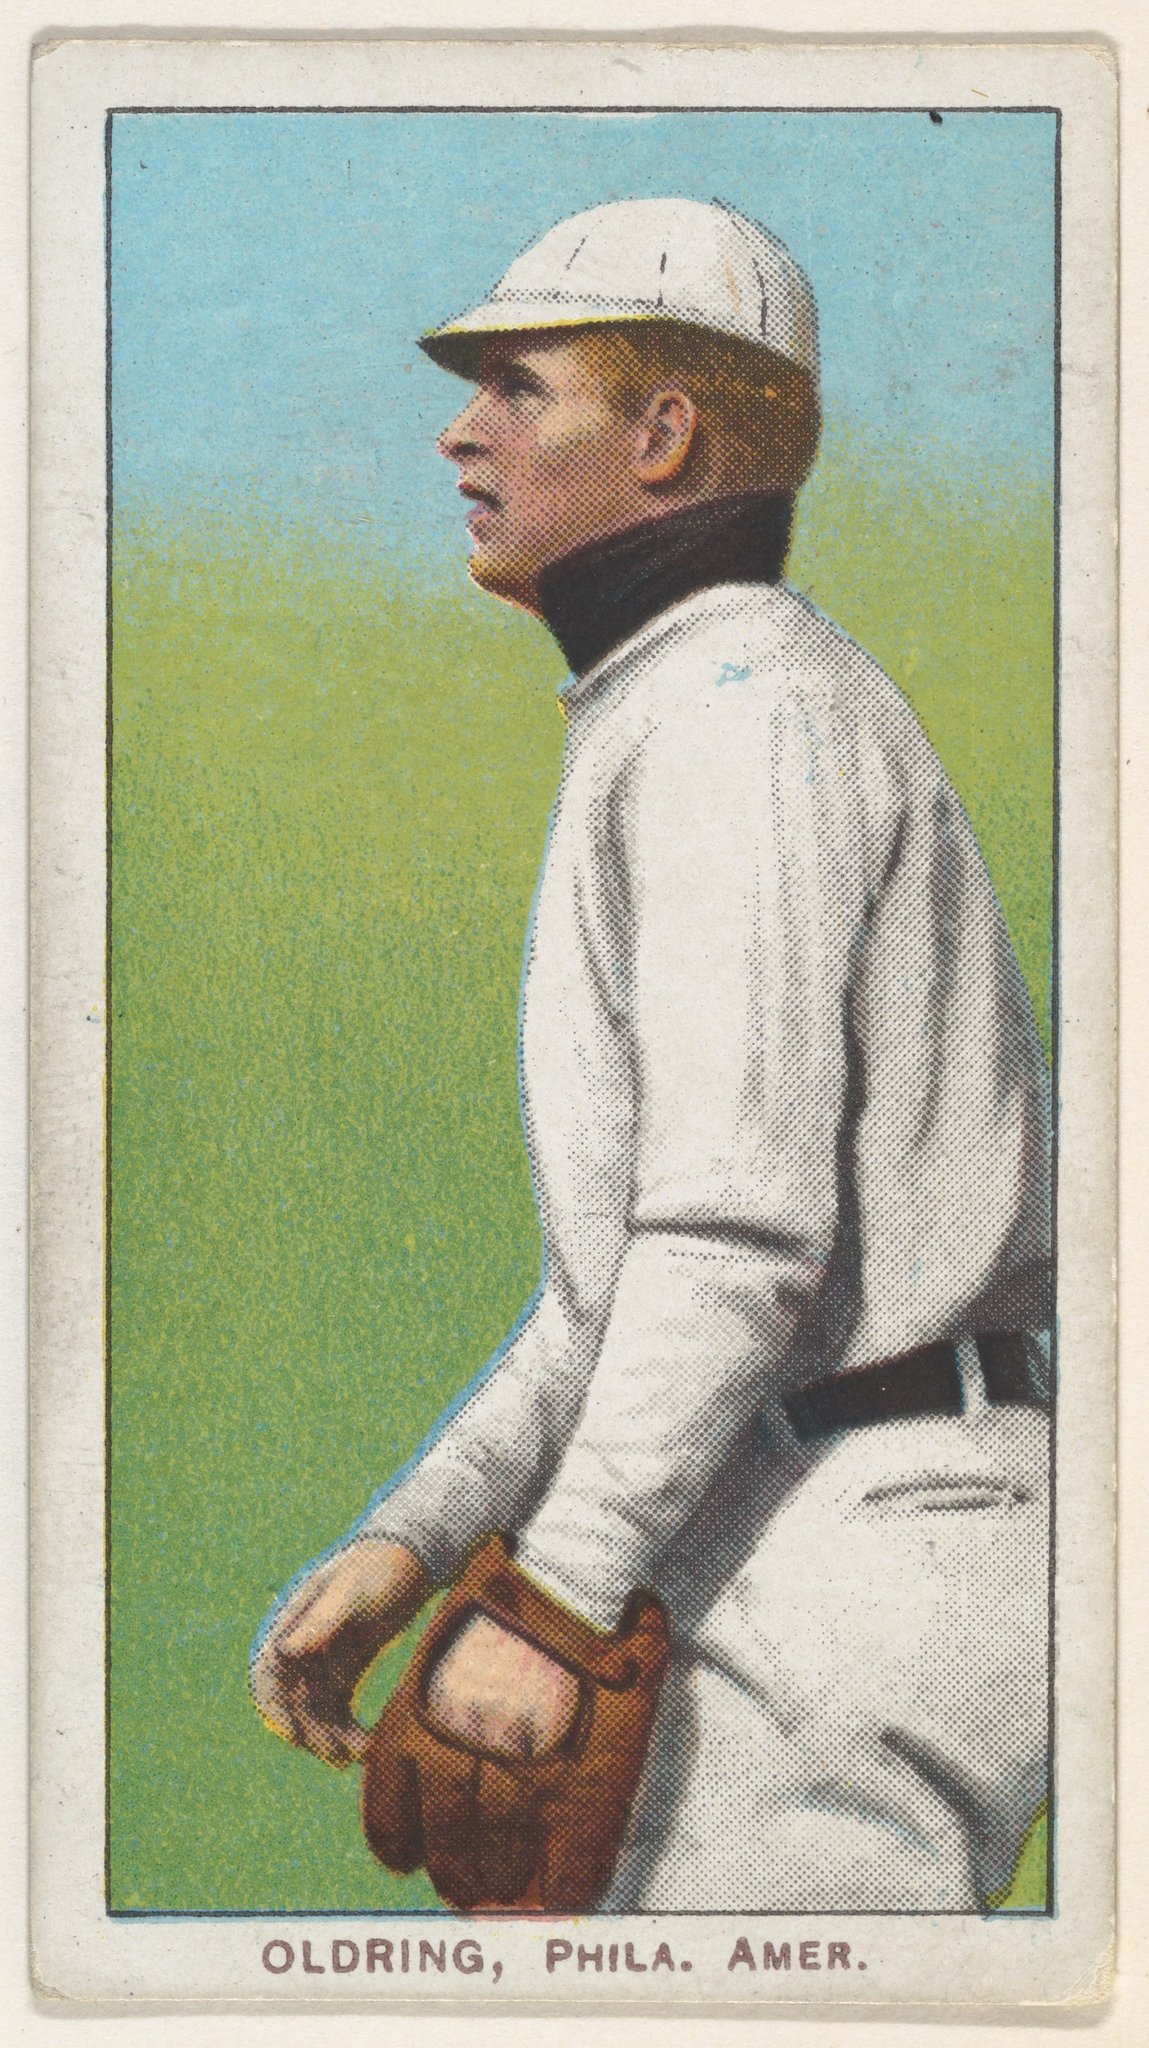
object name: baseball card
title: Oldring, Philadelphia, American League, from the White Border series (T206) for the American Tobacco Company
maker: american tobacco company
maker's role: publisher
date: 1909-1911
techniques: color lithograph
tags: men,baseball,athletes